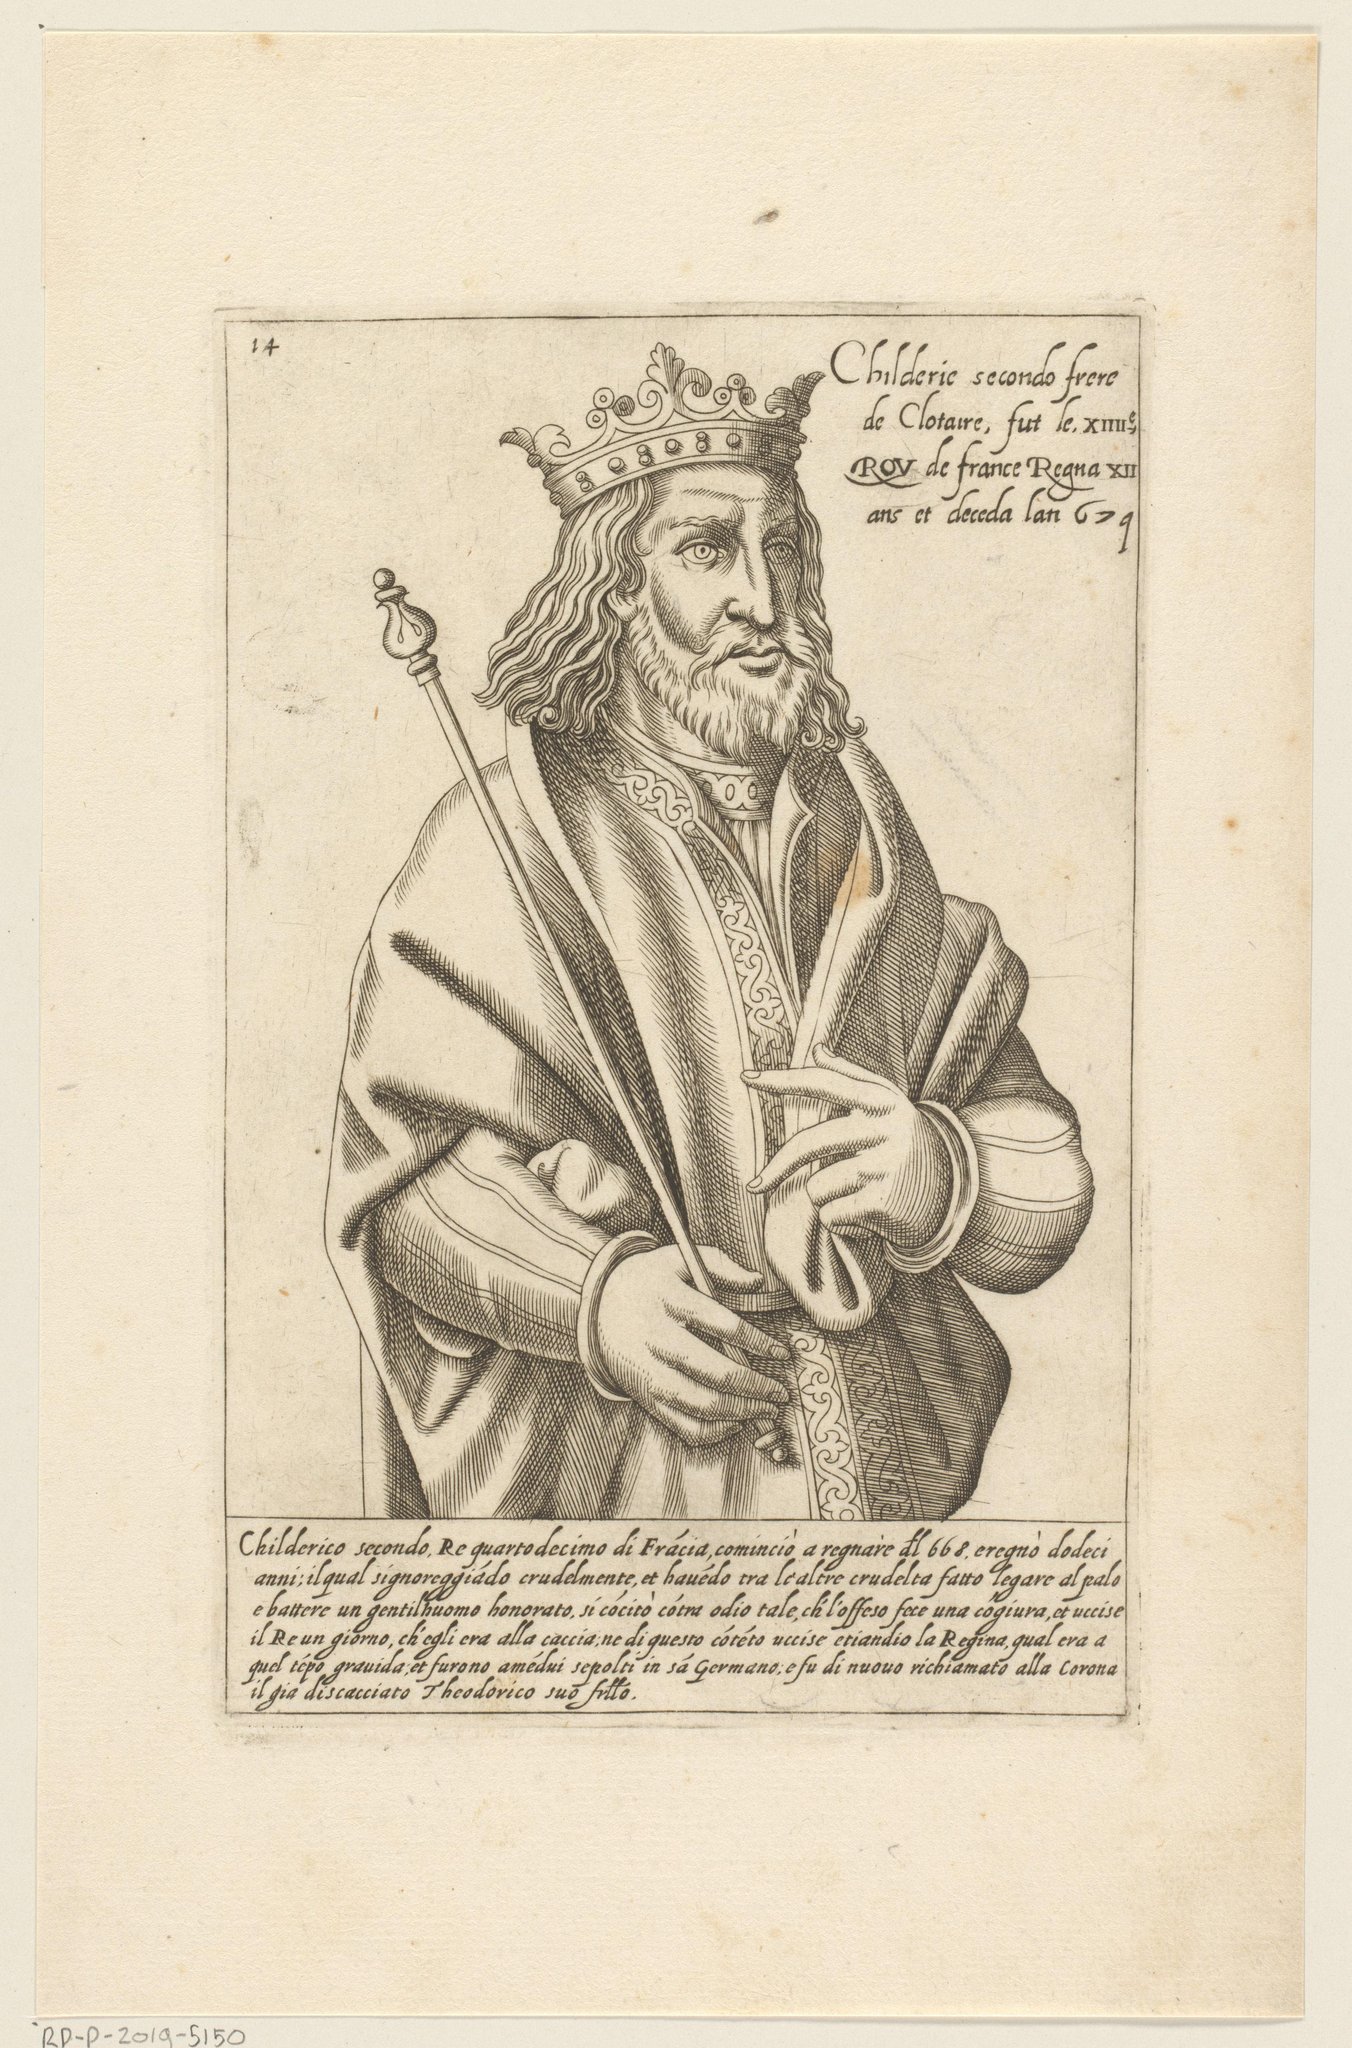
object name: print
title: Portret van Childerik II, koning van Austrasië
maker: Anonymous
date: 1588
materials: paper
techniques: engraving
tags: crown (symbol of sovereignty), sceptre, staff (symbol of sovereignty), historical persons, king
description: Prent voor het eerst gebruikt in: Cronica Breve de i fatti illustri de're di Francia, con le loro effigie dal naturale cominciando da Faramondo (...). Venetië: Bernardo Giunti, 1588. Prent in ieder geval ook gebruikt in de editie van 1590 en mogelijk ook in een Franse uitgave van 1597.